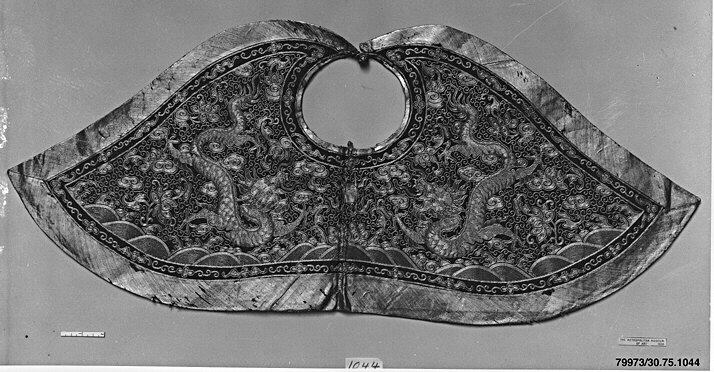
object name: collar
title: Collar for Robe of State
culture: chinese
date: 1701-1900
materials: gold, silk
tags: dragons